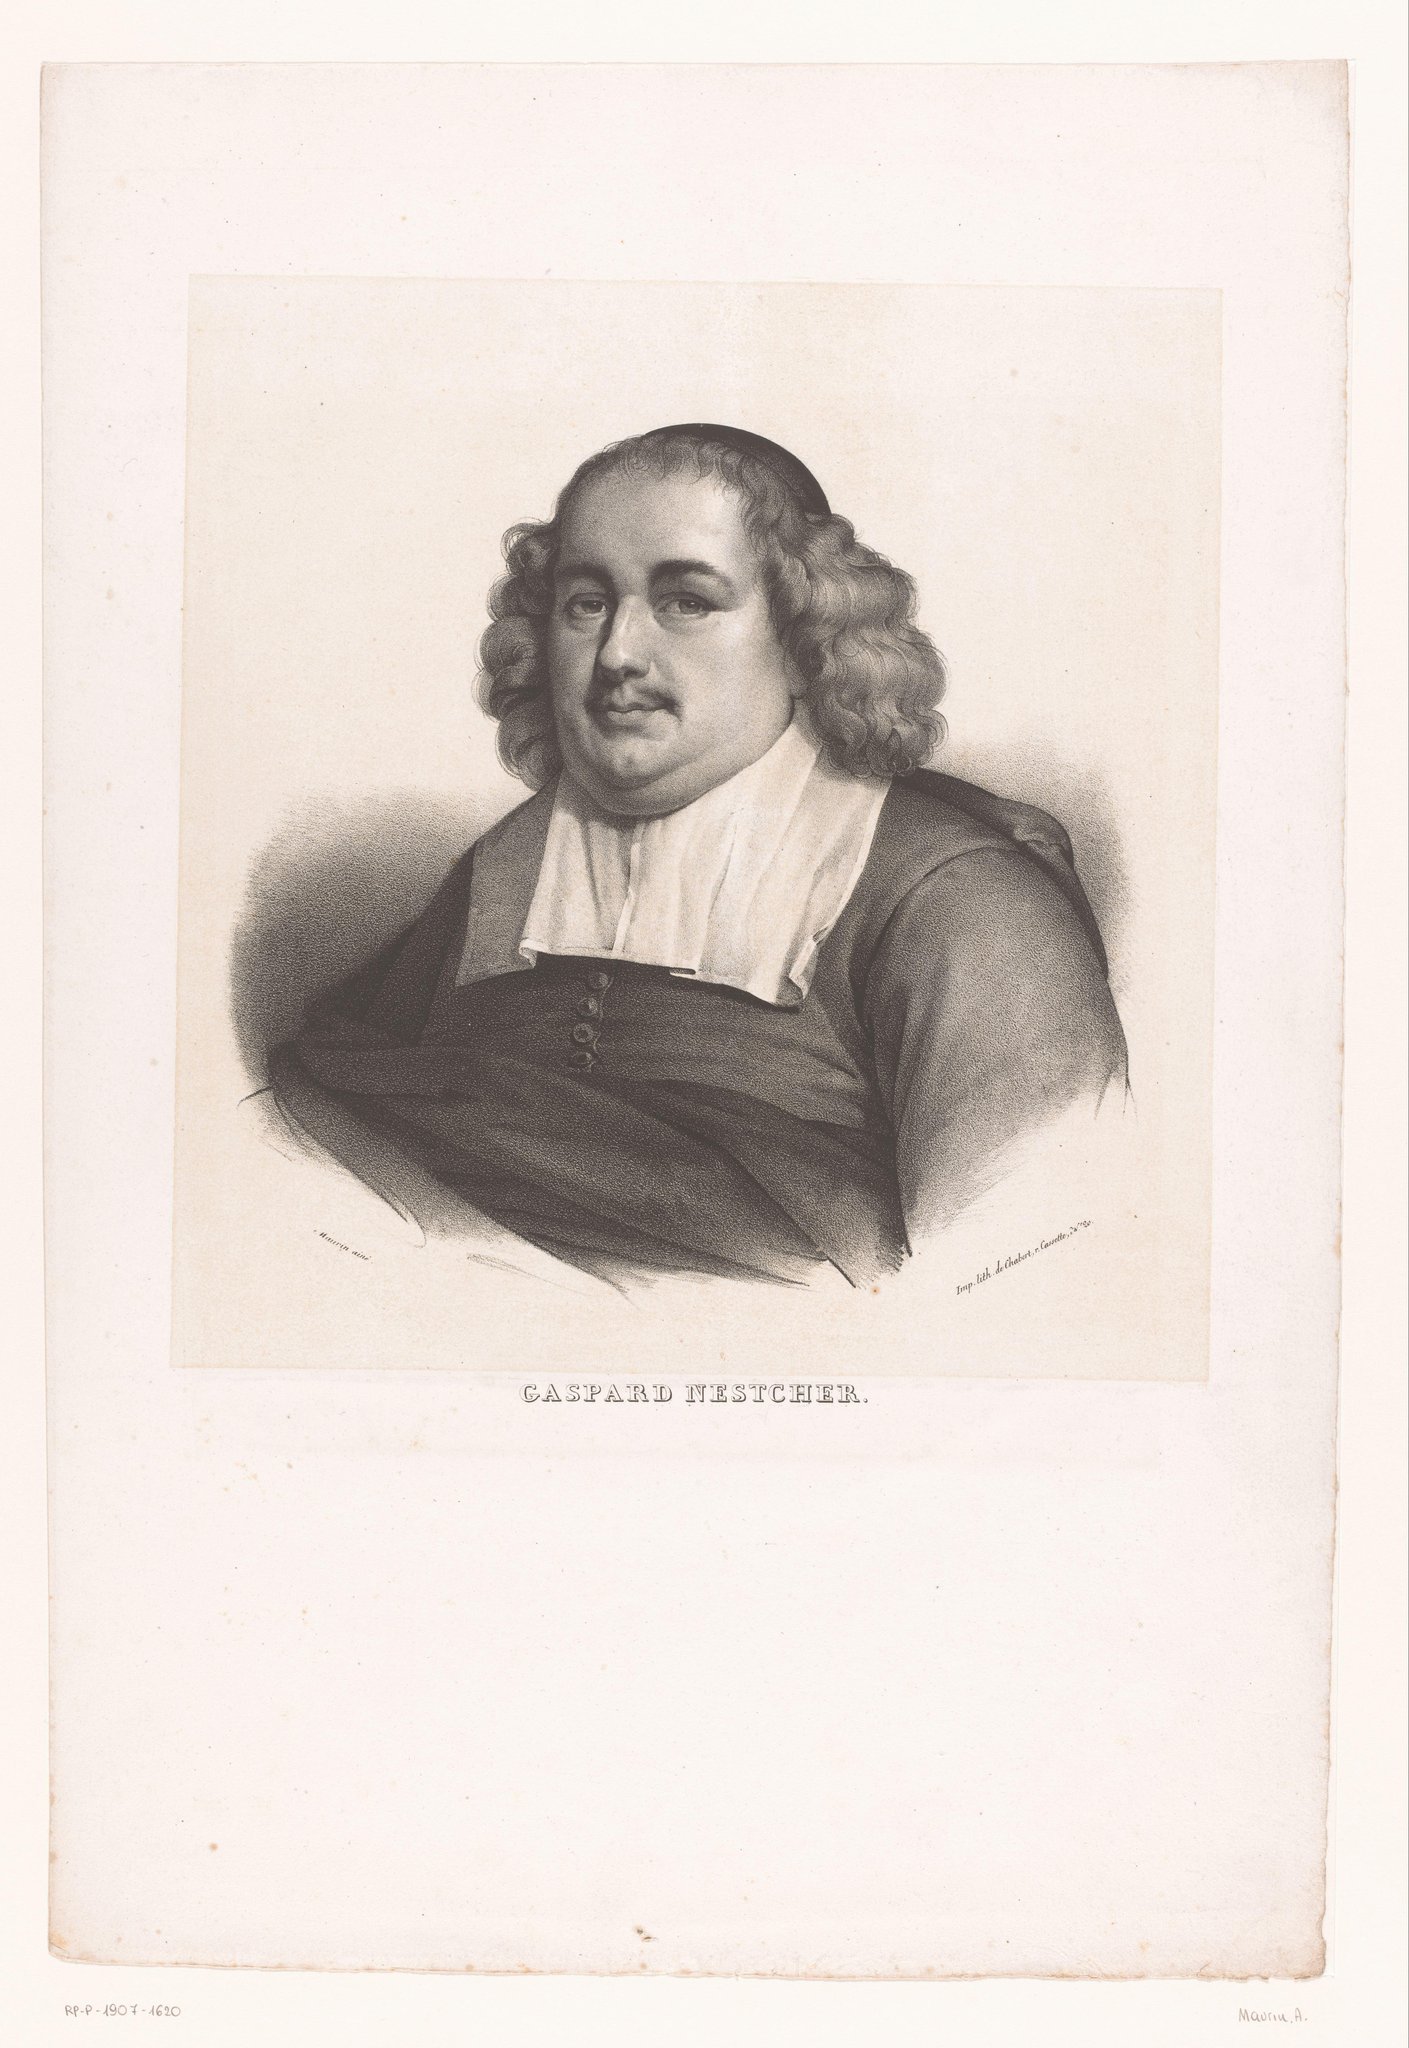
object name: print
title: Portret van Caspar Netscher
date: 1827-1854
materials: paper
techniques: tone lithography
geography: paris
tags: the hague, painter, draughtsman, caspar netscher, historical persons, portrait, self-portrait of painter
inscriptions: collector's mark: Lugt 2228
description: Prent ook gebruikt in: Chabert, Jean Claude. Galerie des peintres ou collection de portraits des peintres les plus célèbres de toutes les écoles. Accompagnée d'une notice sur chacun d'eux, et de copies de dessins originaux / Galerie des peintres ou collection de portraits des peintres les plus célèbres de toutes les écoles. Accompagnée de leur notice historique, de leurs dessins et d'un discours sur les arts. Parijs: Jean Claude Chabert, s.a. [1822-1834]. De samenstelling van tegenwoordig bekende en al dan niet gebonden exemplaren van deze uitgave verschillen. Dit omdat de prenten en bijhorende stukken tekst op inschrijving en waarschijnlijk ook los verkrijgbaar waren.